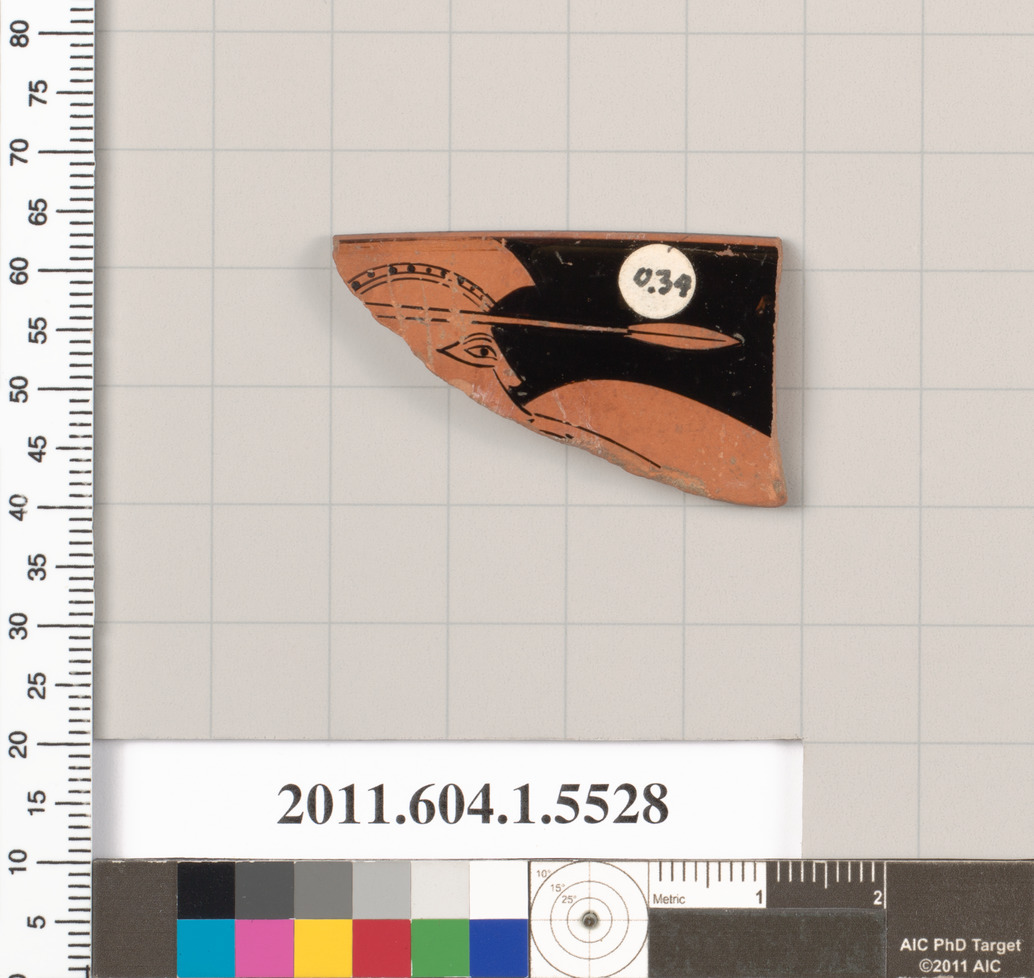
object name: kylix fragment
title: Terracotta rim fragment of a kylix (drinking cup)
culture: greek, attic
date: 510-500 BCE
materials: terracotta